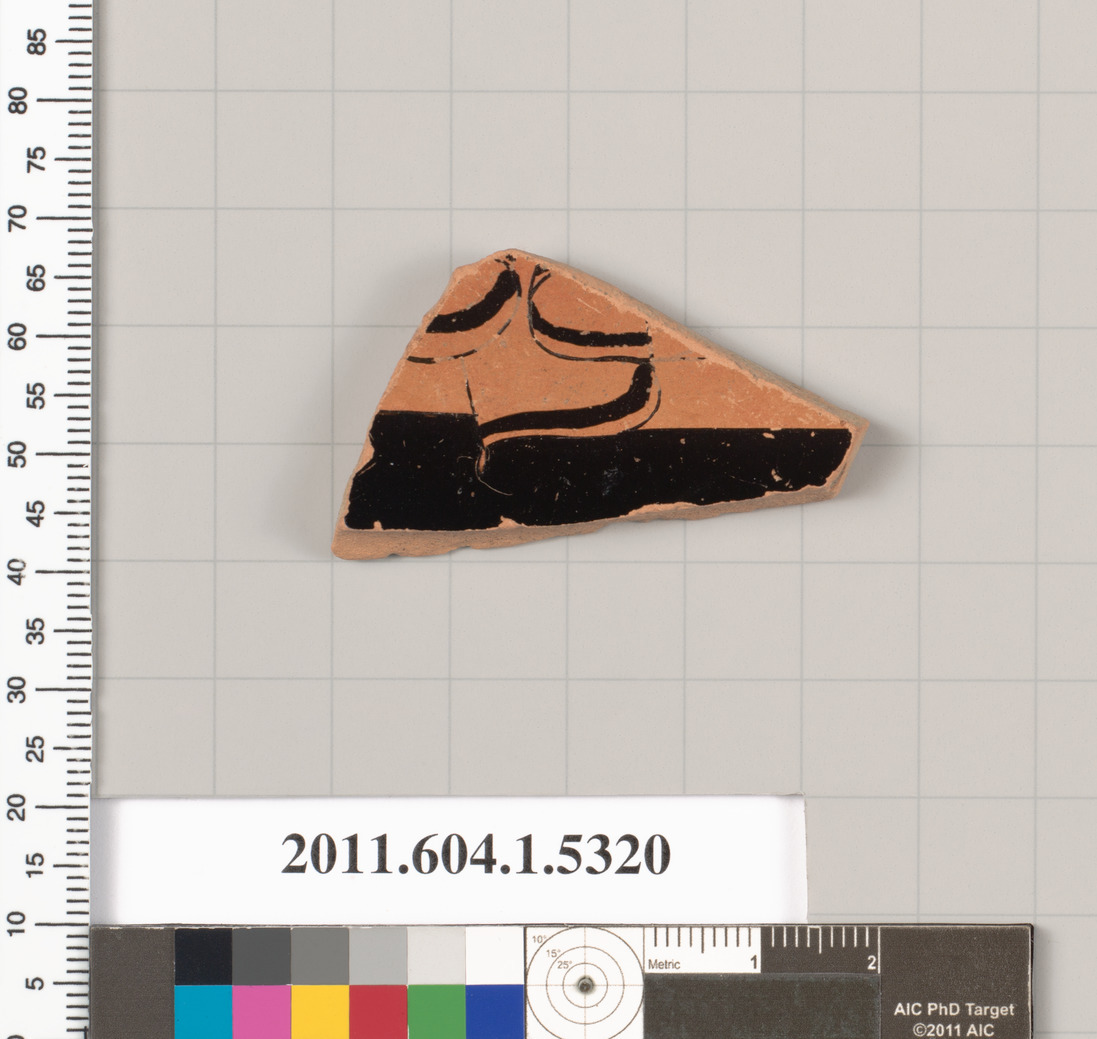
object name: kylix fragment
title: Terracotta fragment of a kylix (drinking cup)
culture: greek, attic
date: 500-480 BCE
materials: terracotta